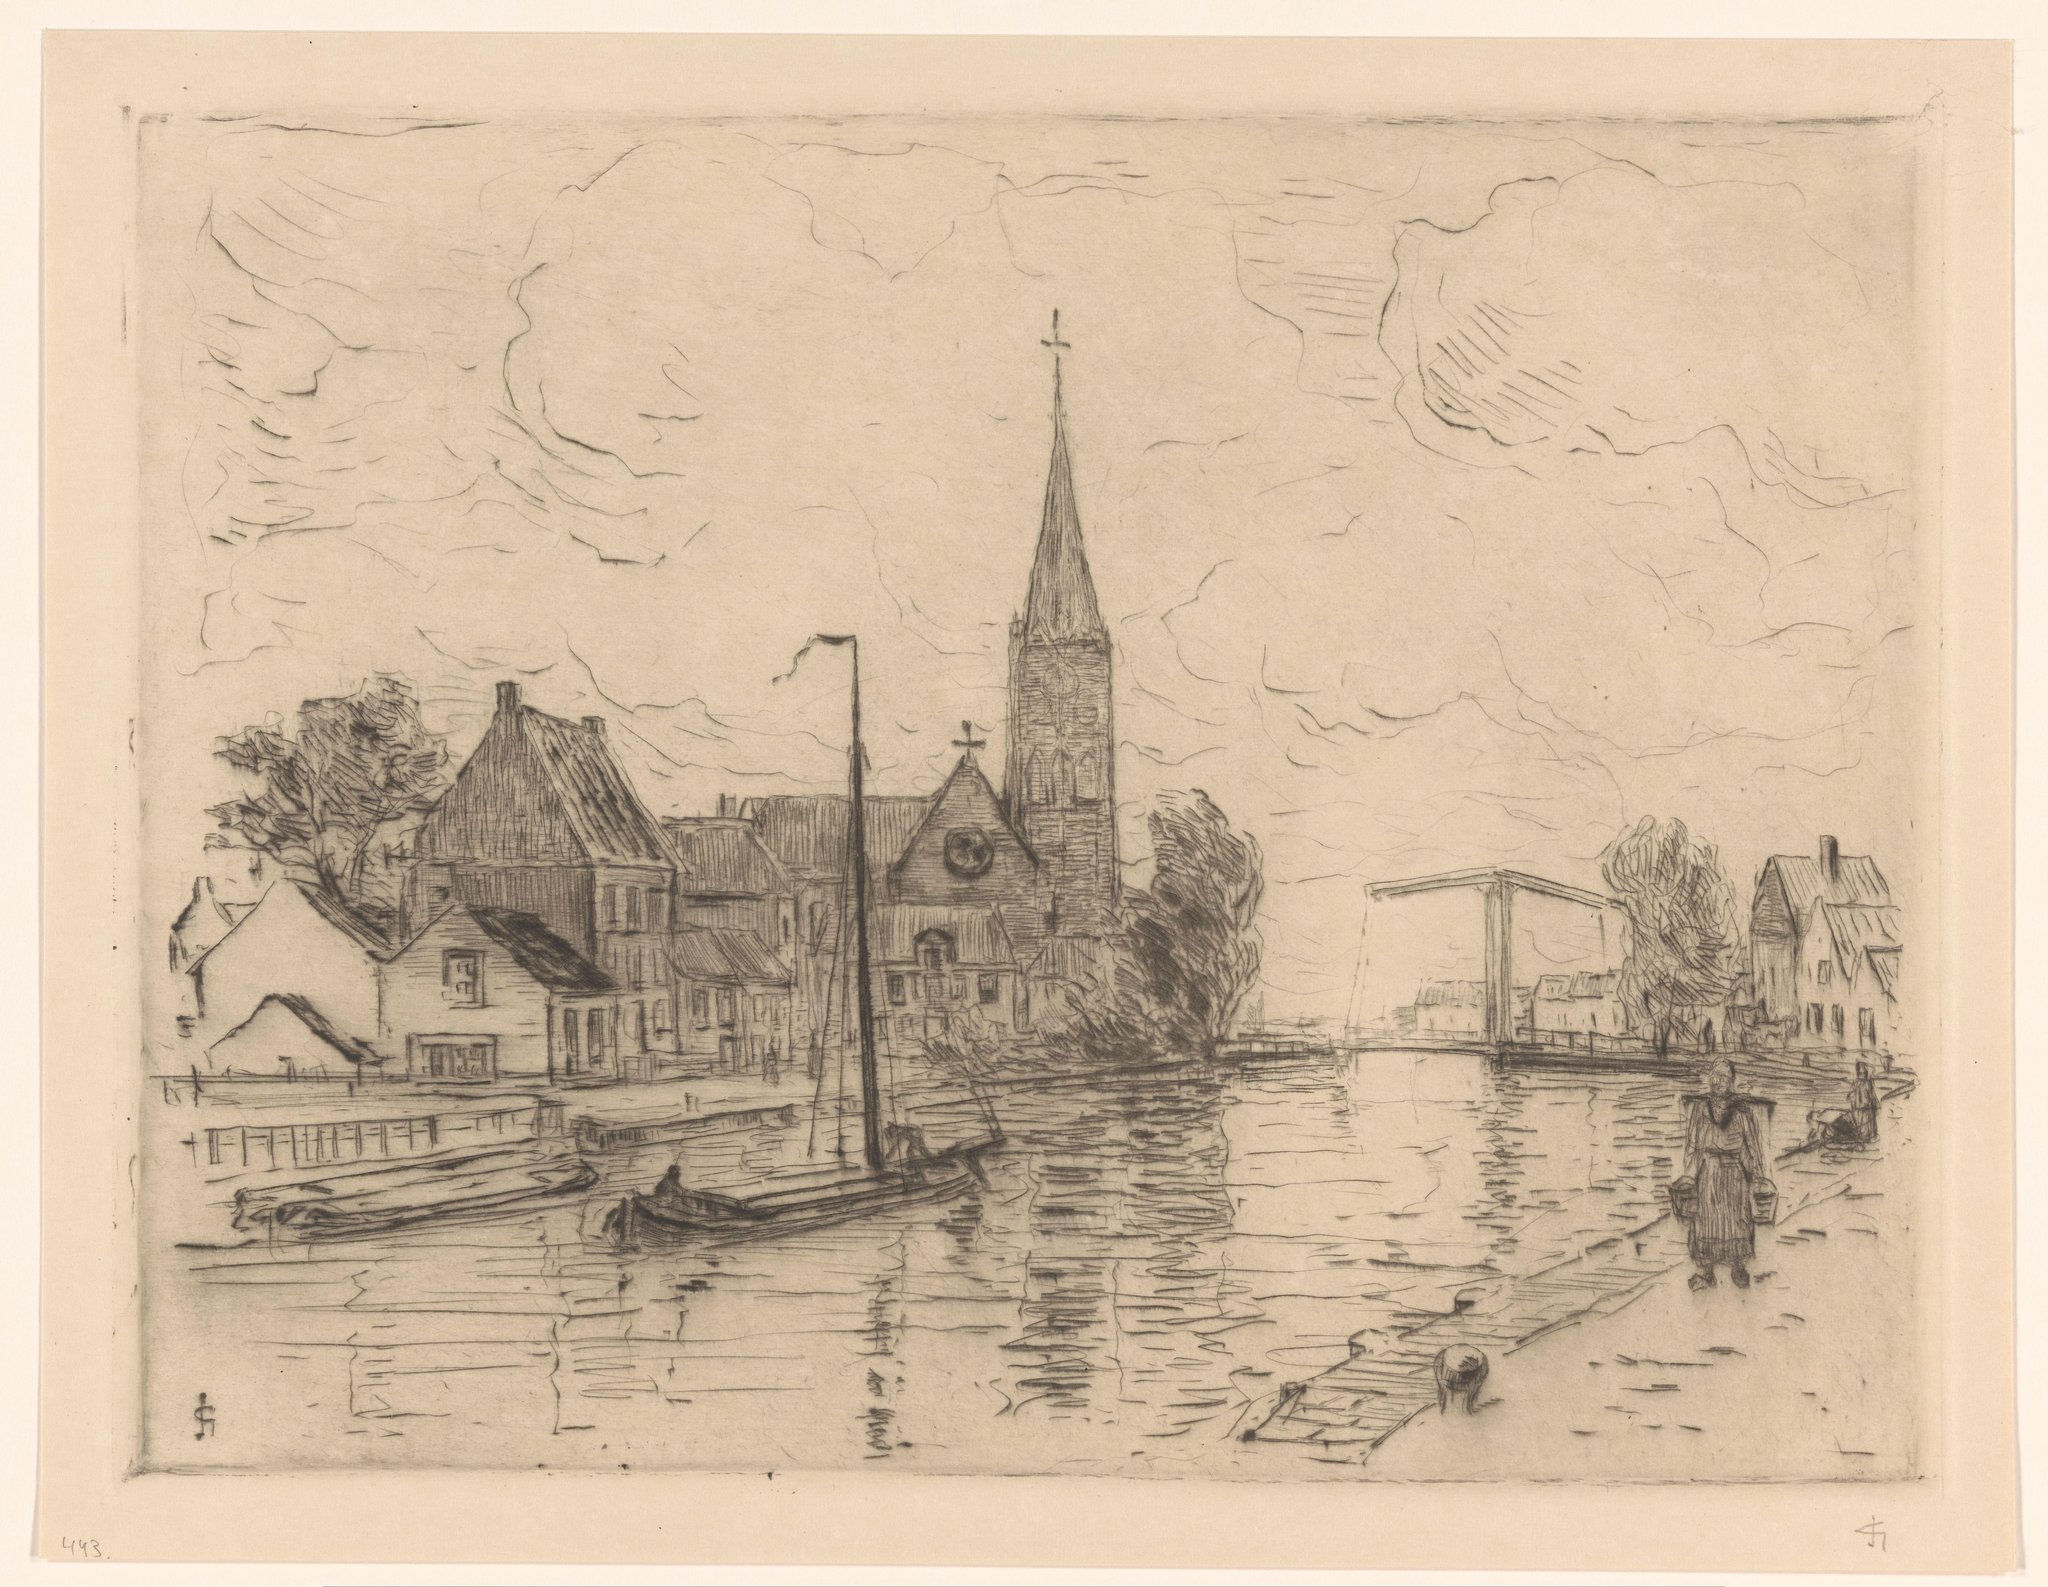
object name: print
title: Gezicht op de Vliet in Leidschendam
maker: carel nicolaas storm van s-gravesande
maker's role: draughtsman, print maker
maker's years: 1841-1924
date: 1851-1902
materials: paper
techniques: drypoint, etching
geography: netherlands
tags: church (exterior), carrying something with yoke, bridge in city across river, canal, etc.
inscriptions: collector's mark: Lugt 2228, number: ‘443’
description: Mogelijk vermeld in: Storm van 's-Gravesande, Charles. Catalogue des eaux-fortes et lithographies. New York: s.n., 1903, of in een onbekende latere uitgave van het manuscript. Vermoedelijk vermeld als catalogusnummer 443.